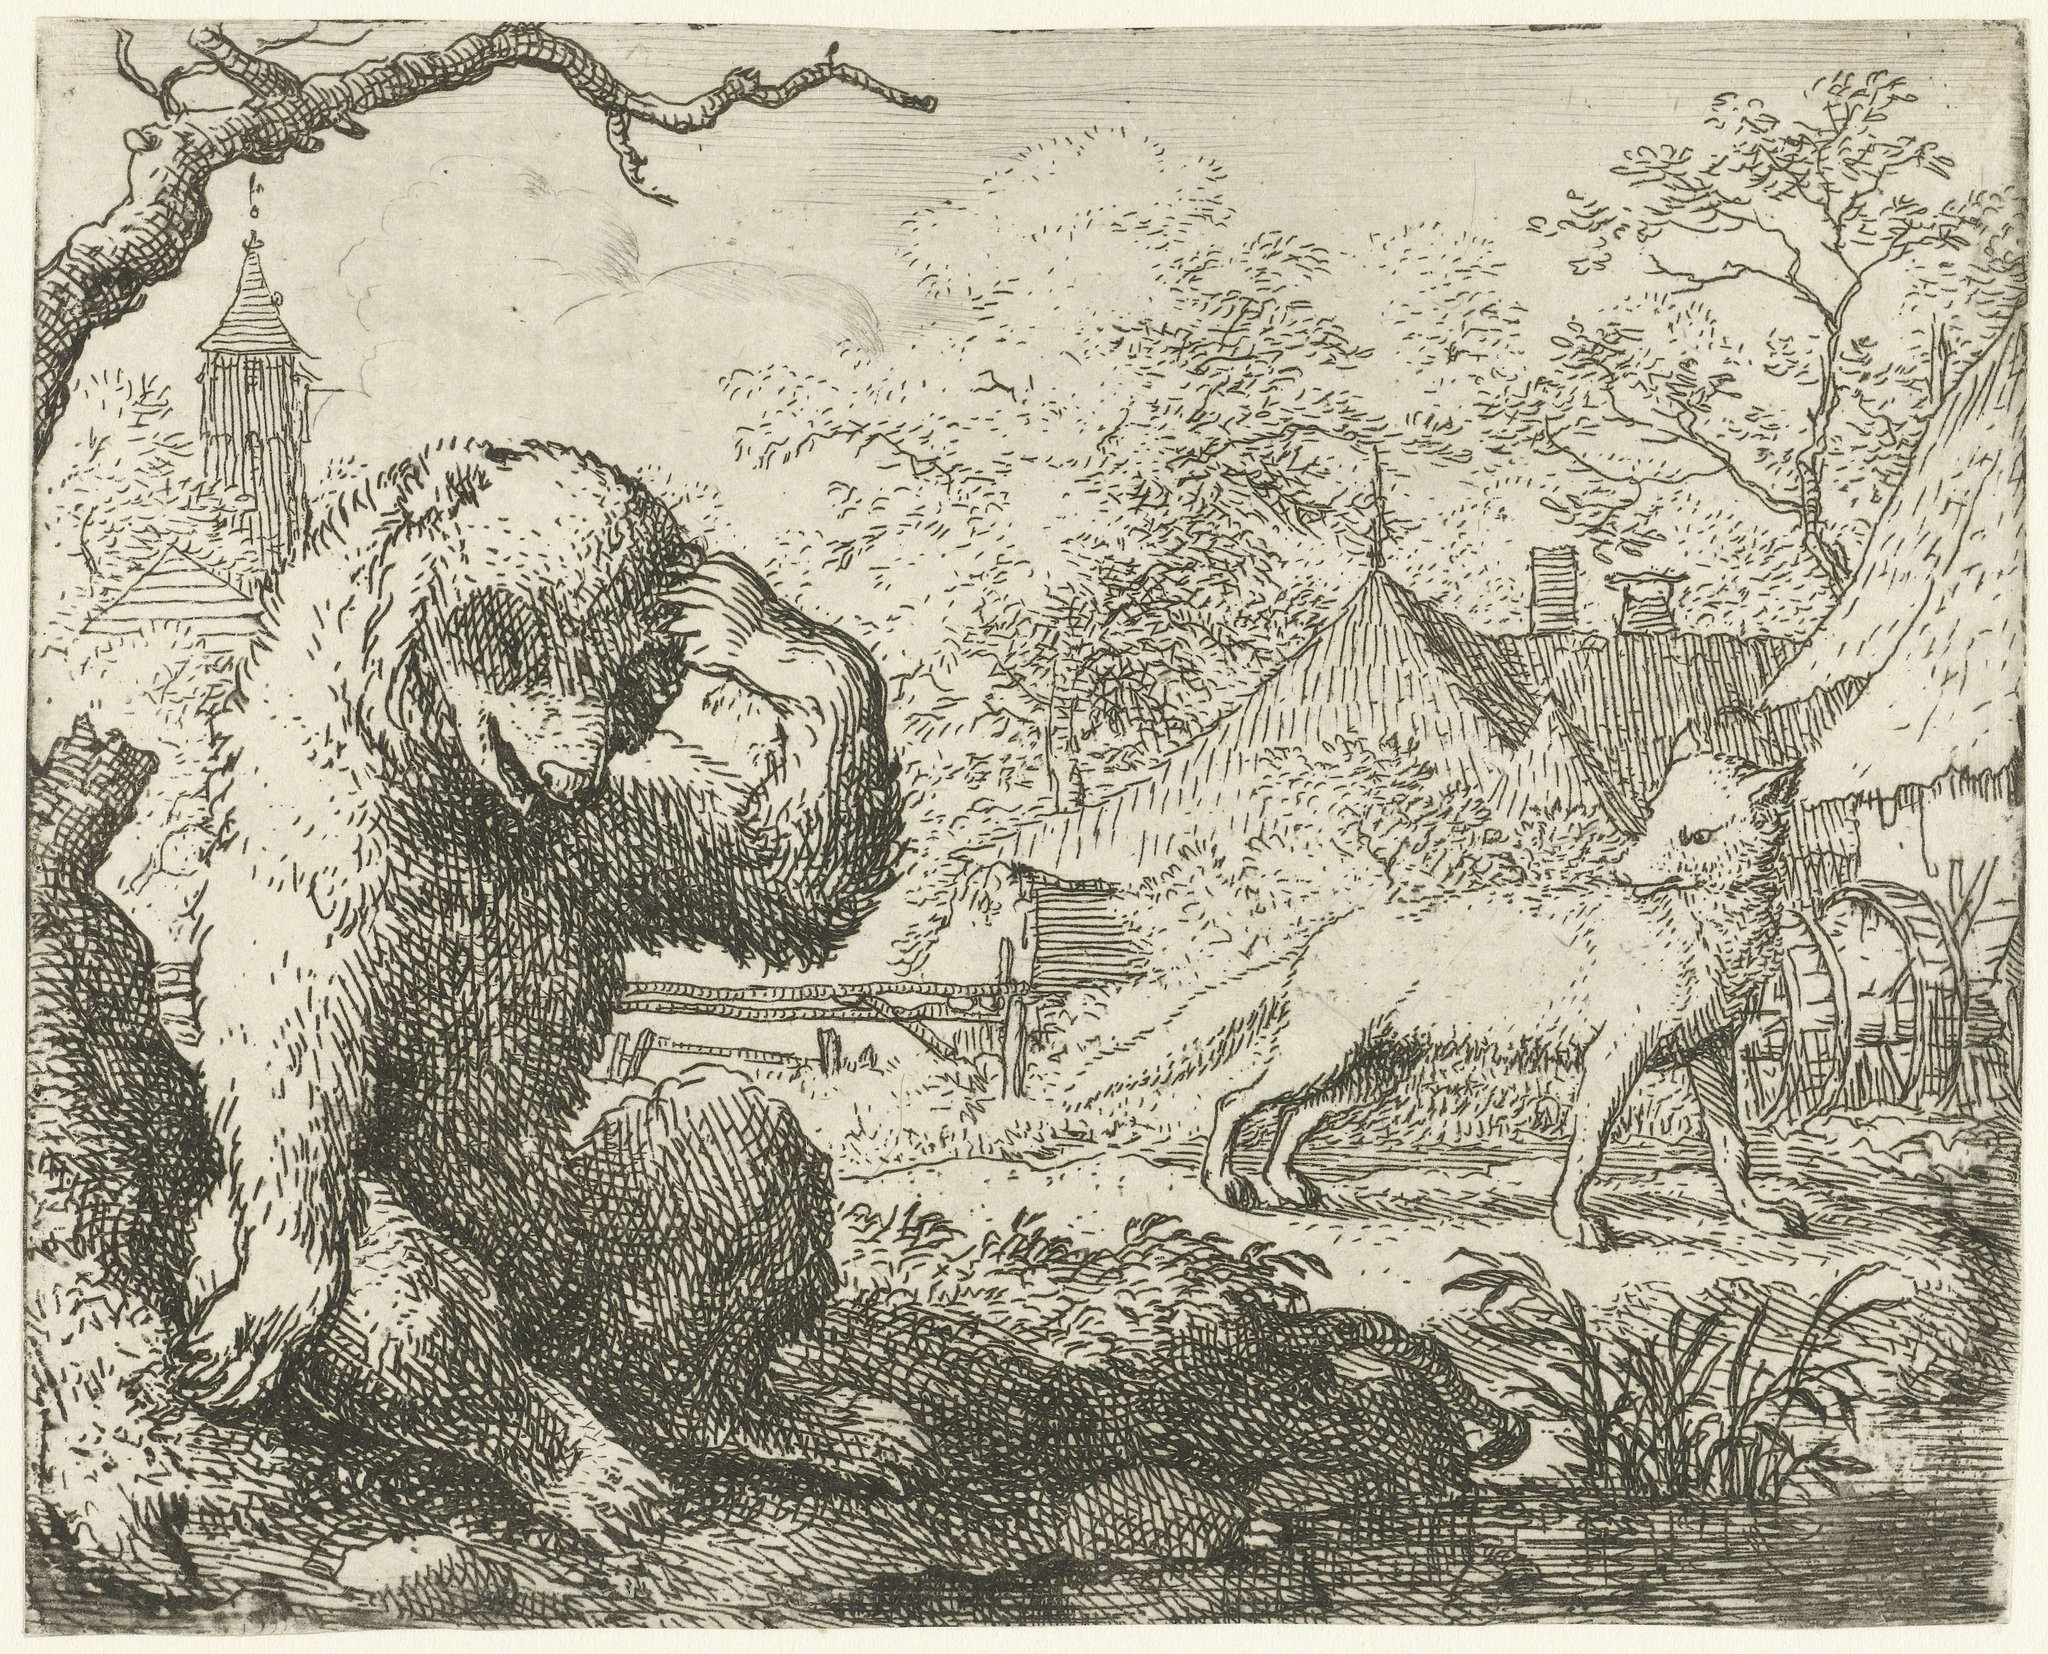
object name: print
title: Reinaert de vos berispt de gewonde Bruun de beer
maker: allaert van everdingen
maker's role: draughtsman, painter, print maker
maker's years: 1621-1675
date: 1665-1675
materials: paper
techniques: etching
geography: netherlands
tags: fable of reynard the fox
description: De gewonde Bruun de beer zit met zijn poot bij zijn kop tegen een boomstam aan. Iets verderop staat Reinaert de vos.